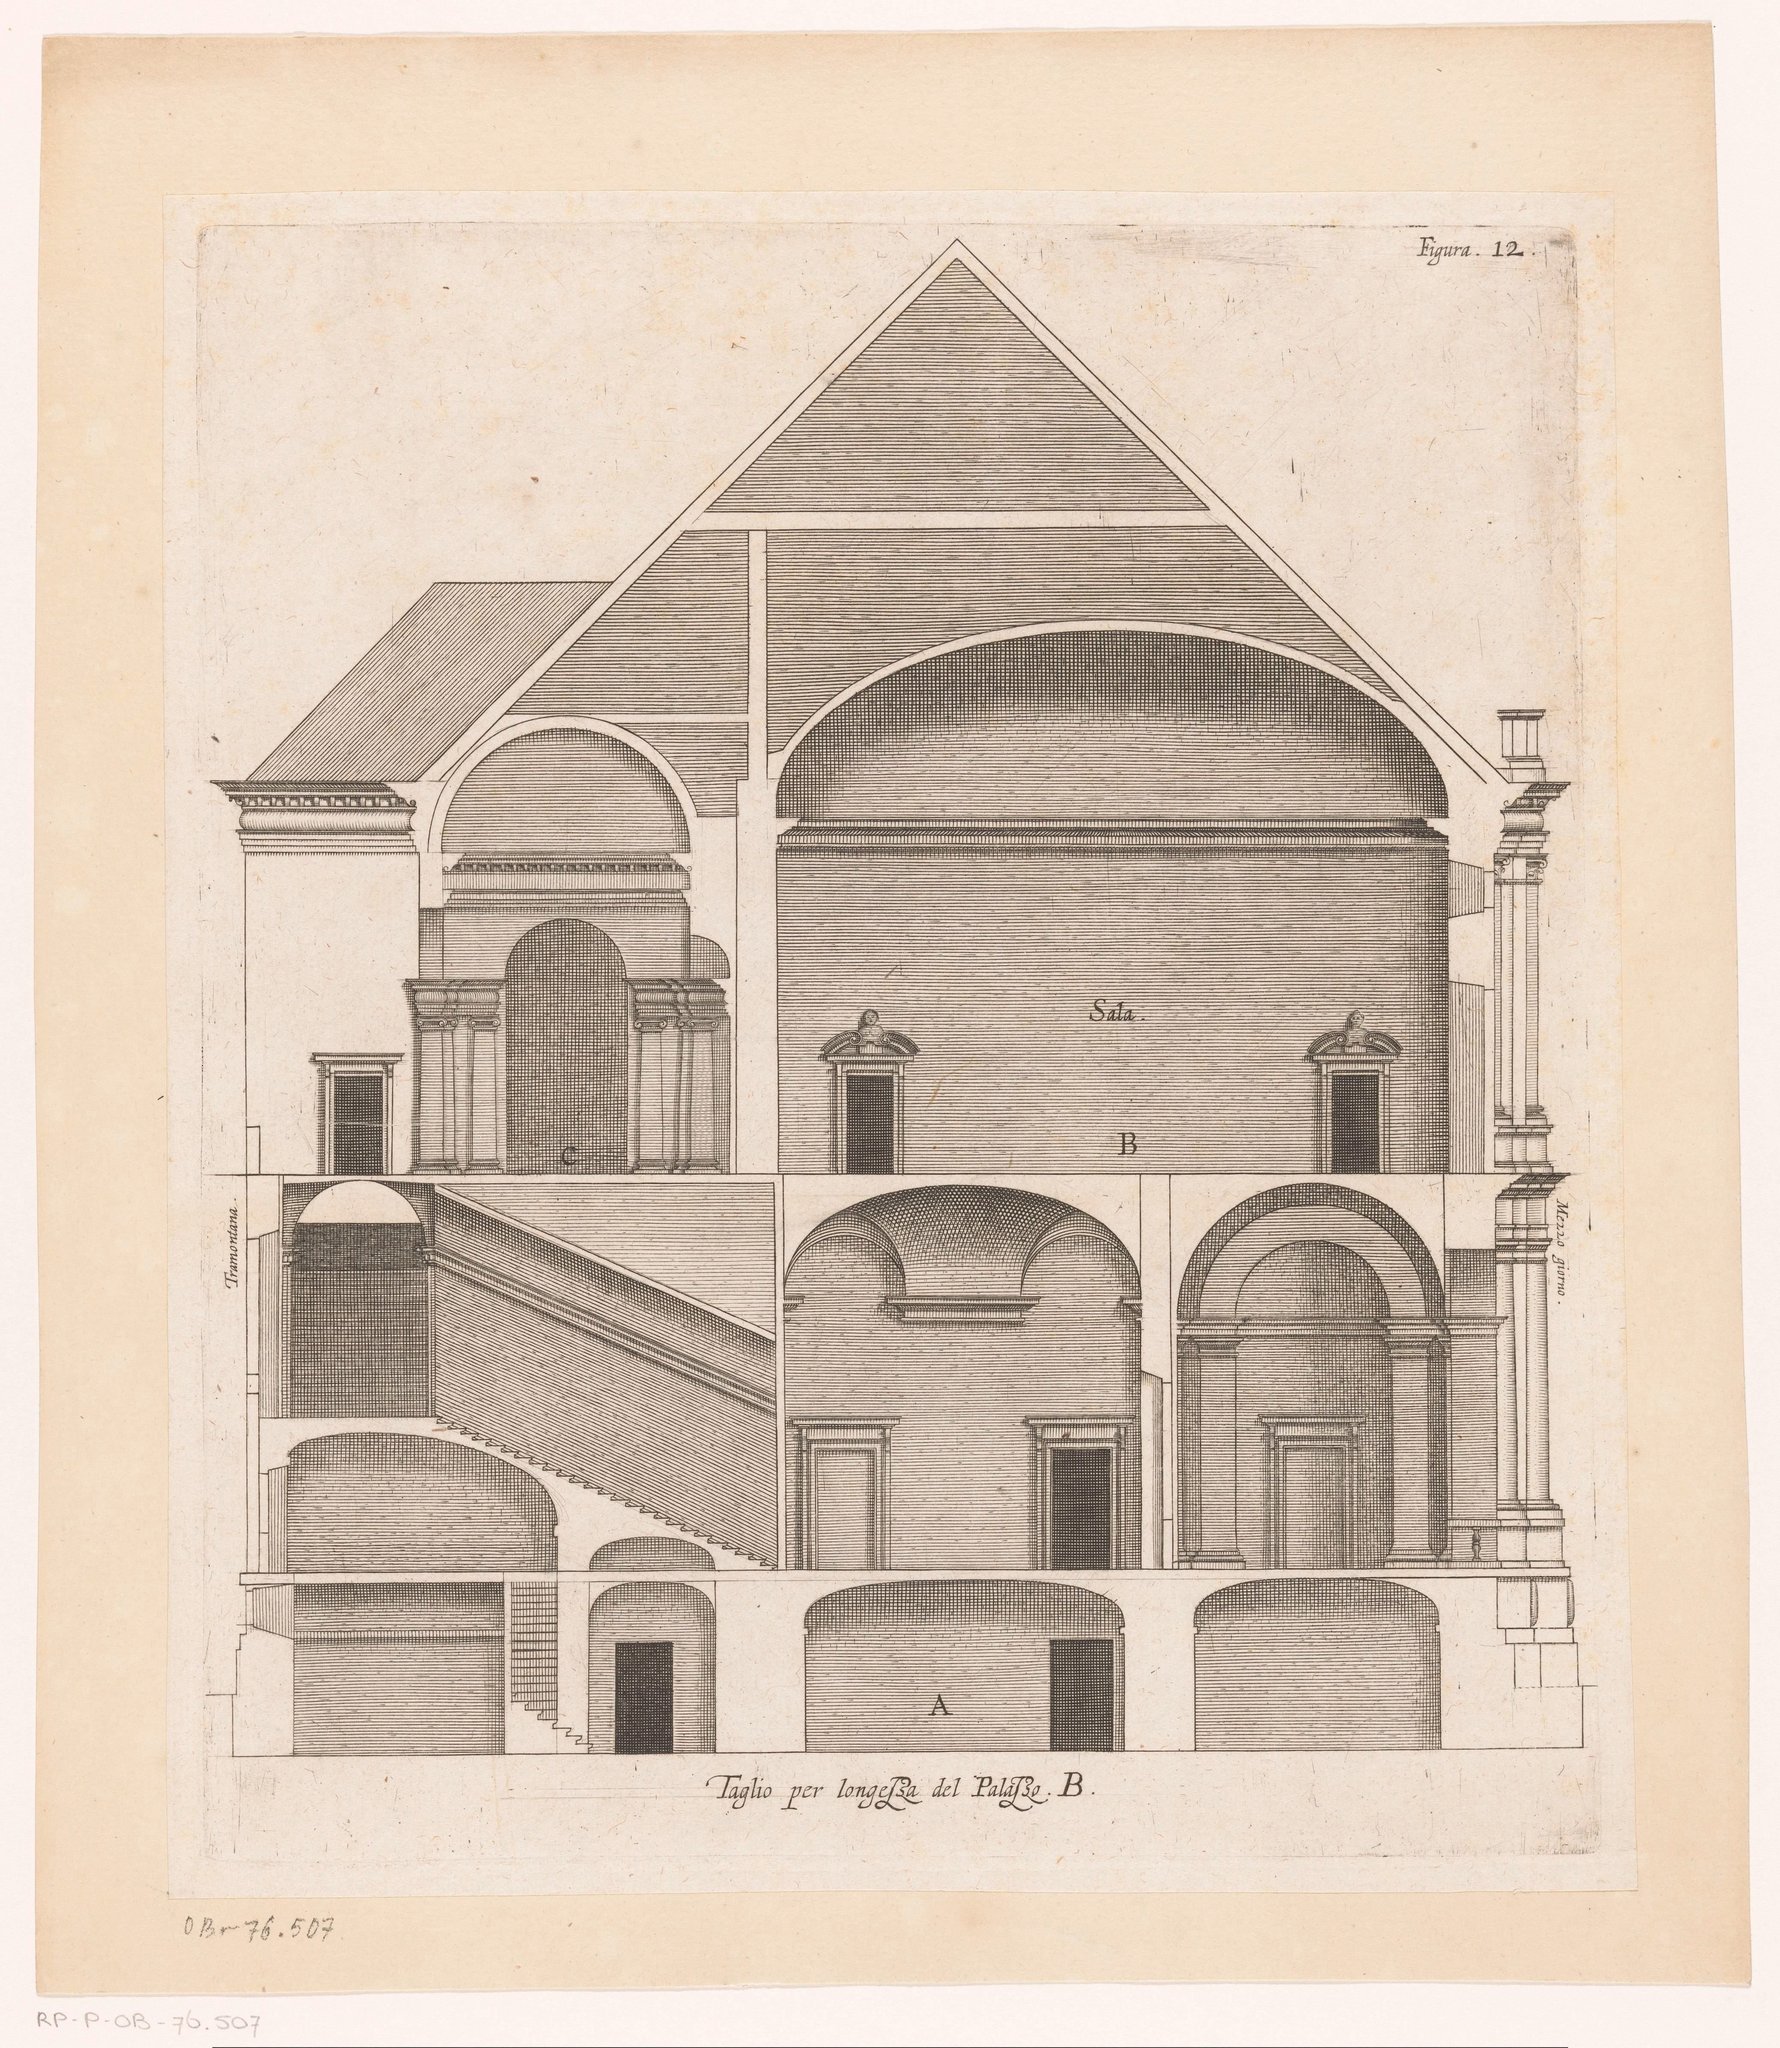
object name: print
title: Langsdoorsnede van de Villa Giustiniani-Cambiaso te Genua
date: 1622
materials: paper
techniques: engraving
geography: antwerp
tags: hôtel, i.e. small palace in city - aa - civic architecture: inside, section ~ architectural design or model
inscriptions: collector's mark: Lugt 240